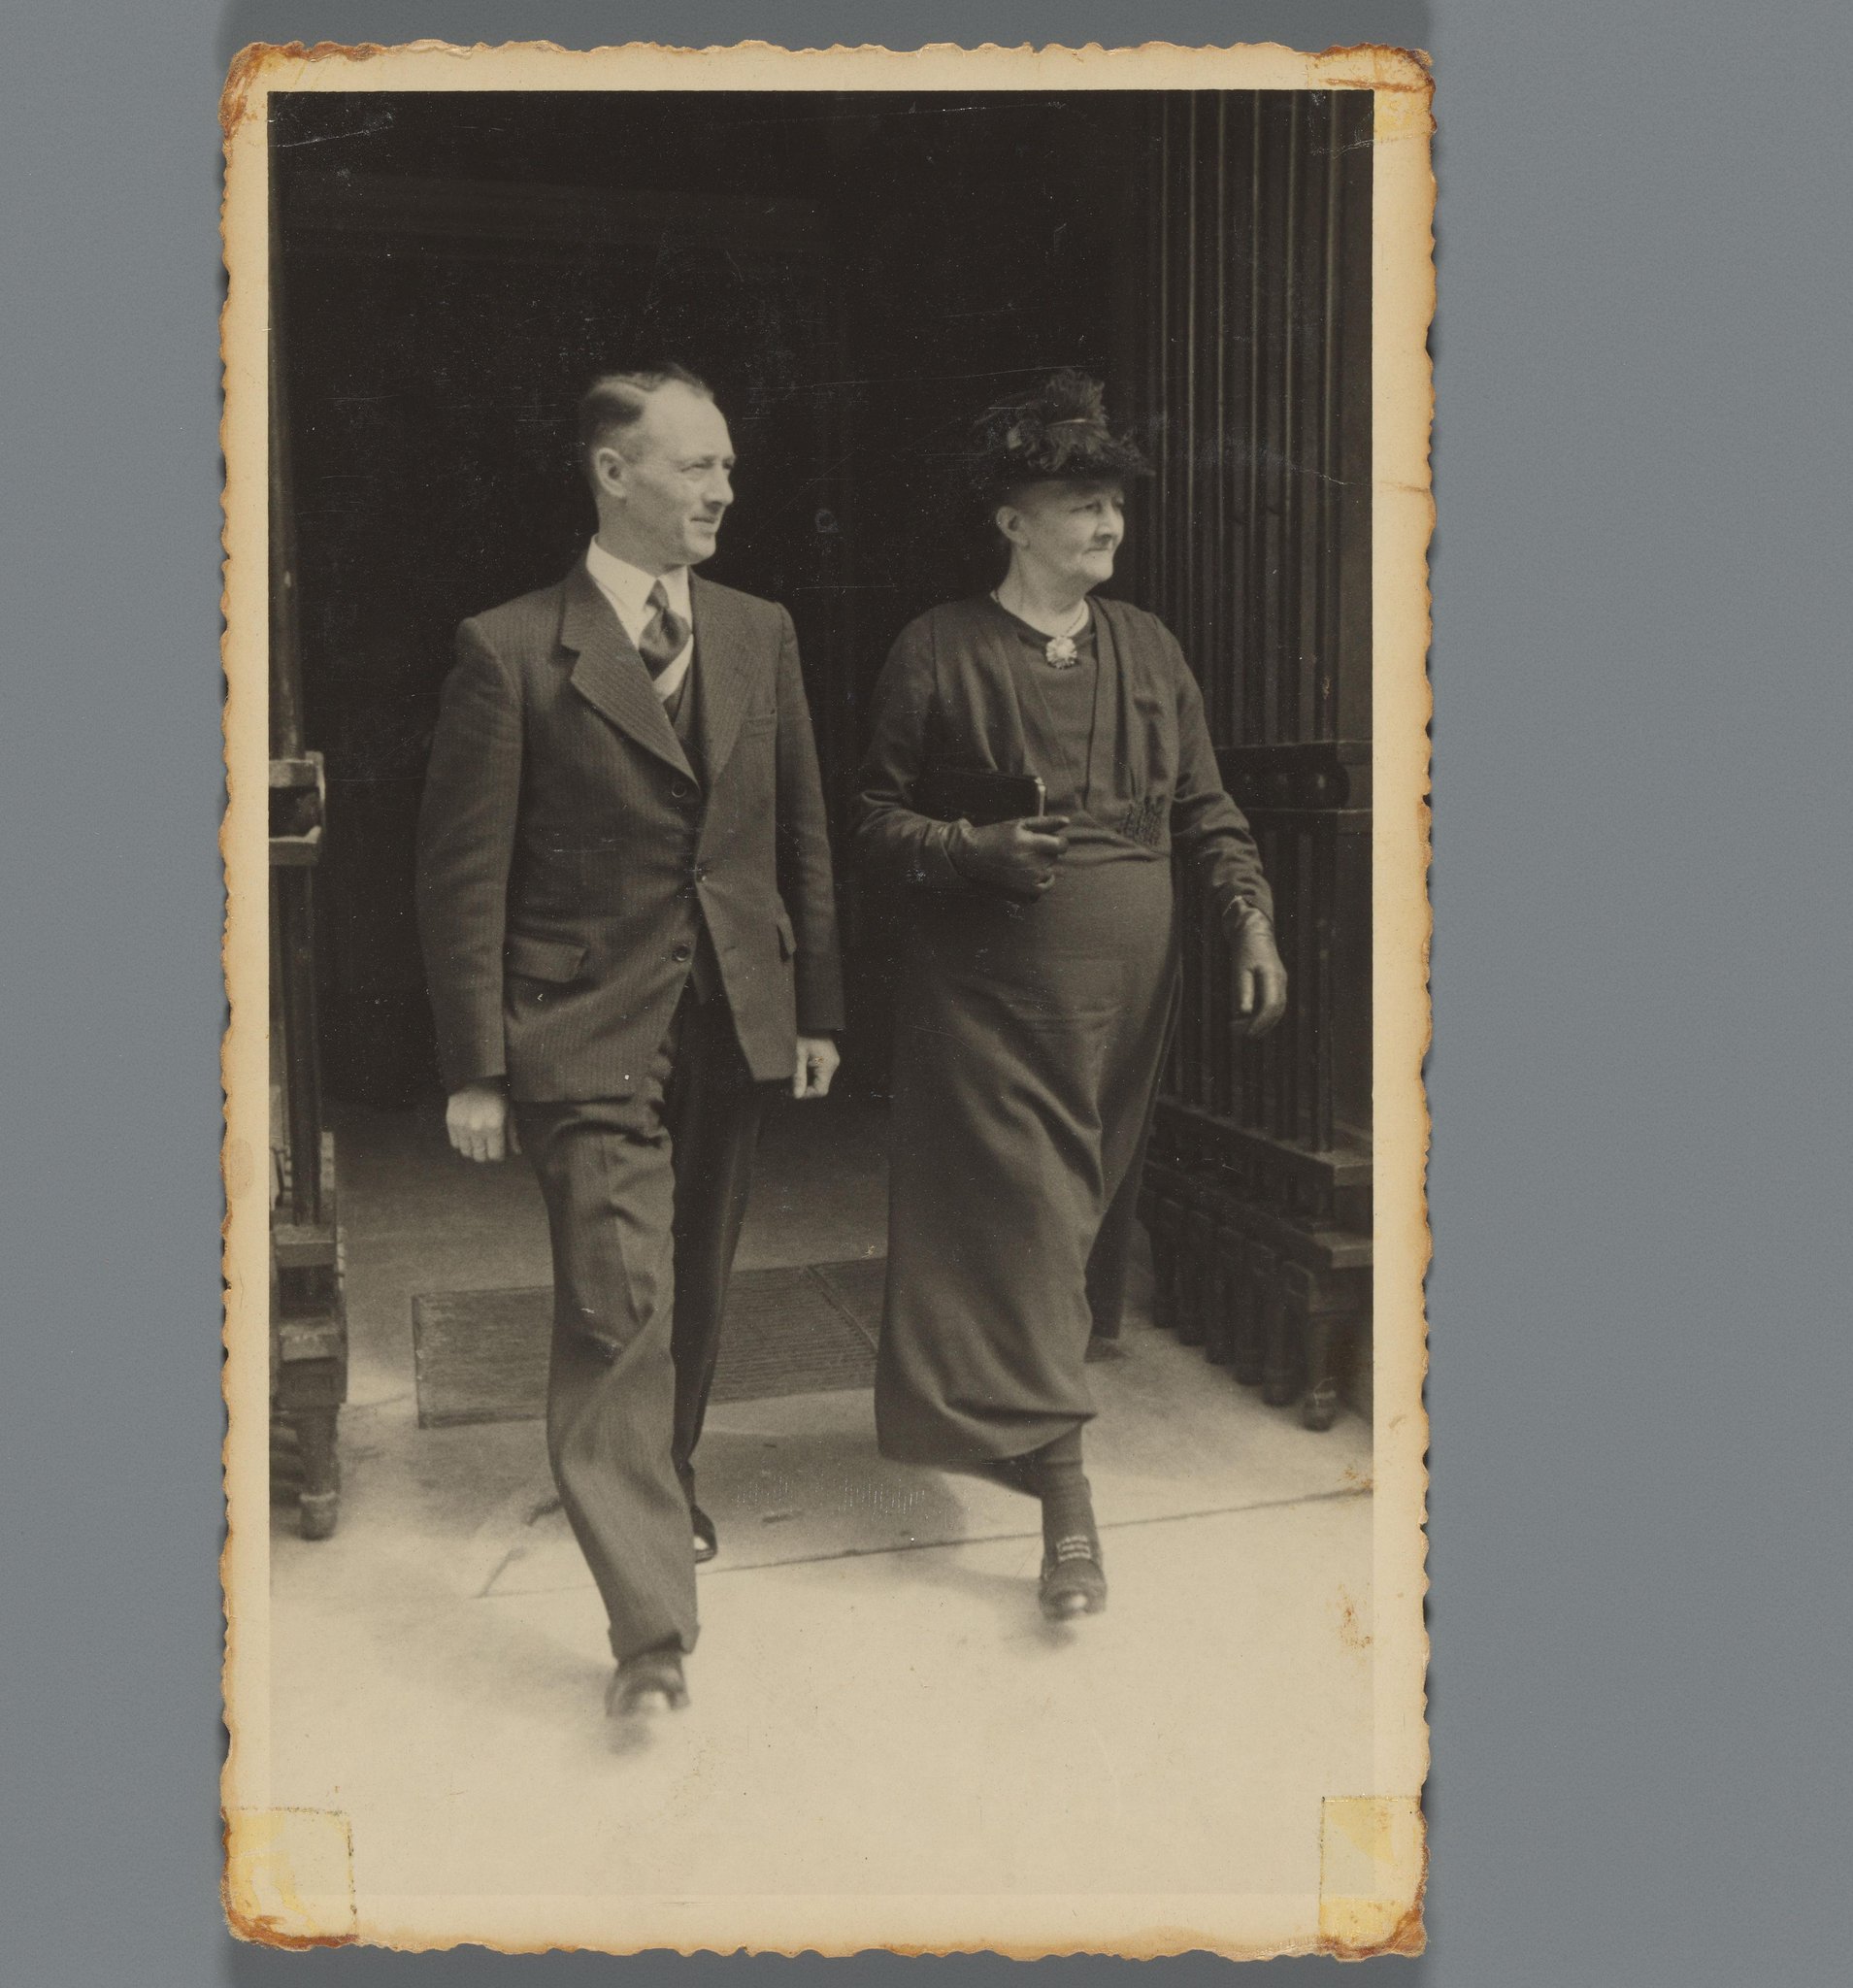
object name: ansichtkaart, prentbriefkaart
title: Portret van twee lopende mensen, aangeduid als de Jong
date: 1905-1930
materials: paper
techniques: gelatin silver print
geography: hilversum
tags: anonymous historical persons portrayed in a double portrait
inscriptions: inscription: ‘fam De Jong’, address: ‘JOH. GERARDTSWEG 120/ HILVERSUM/ tél 5200’, number: ‘405994’